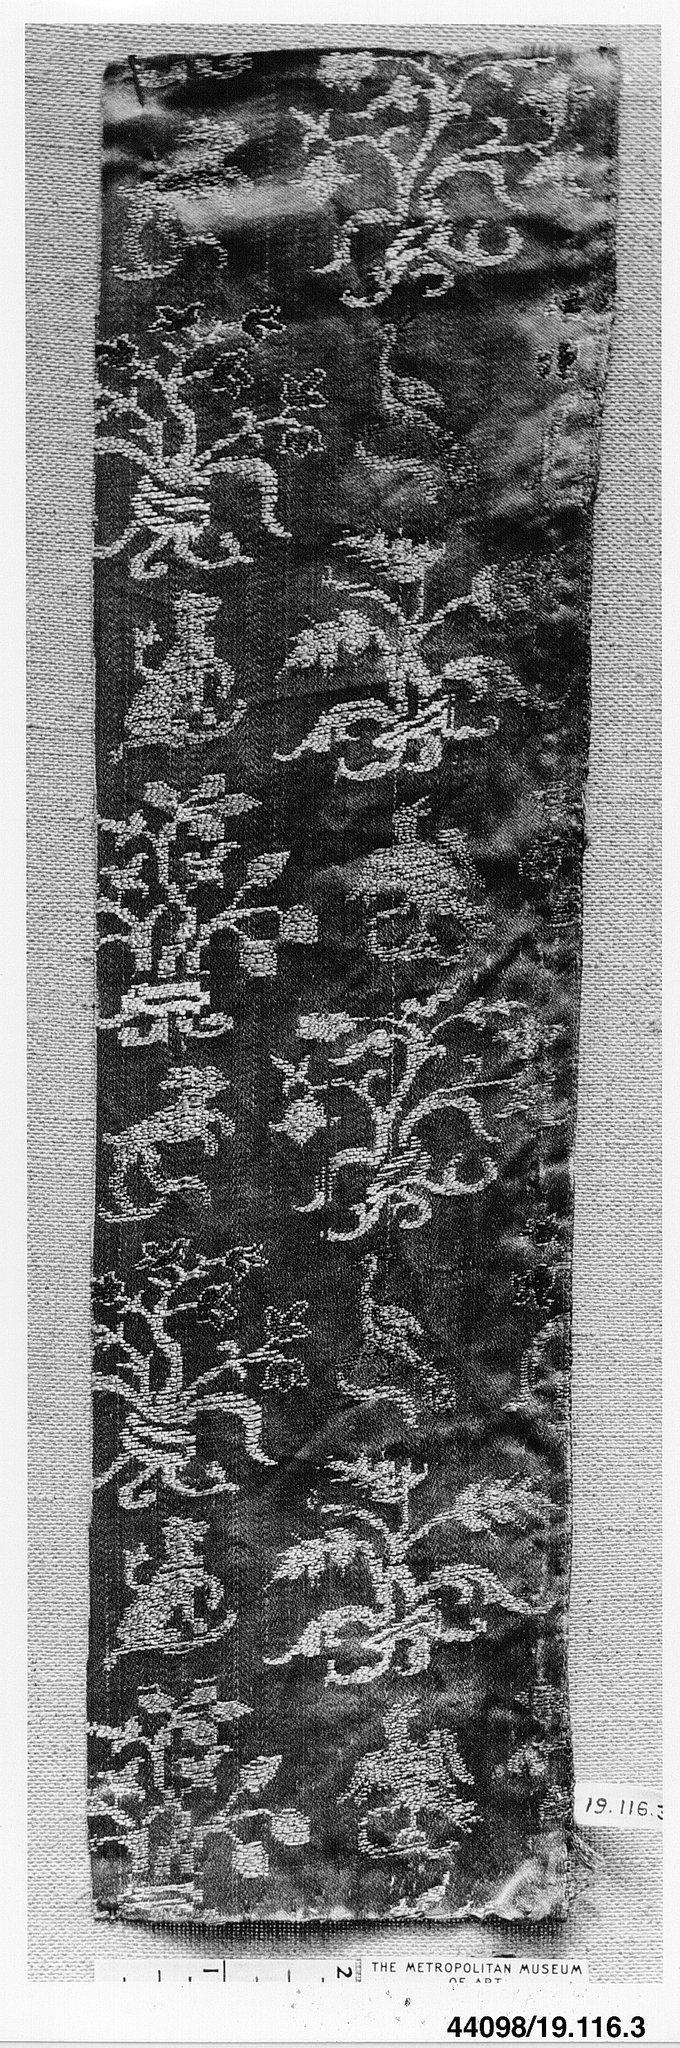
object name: piece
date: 1601-1633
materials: silk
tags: leaves